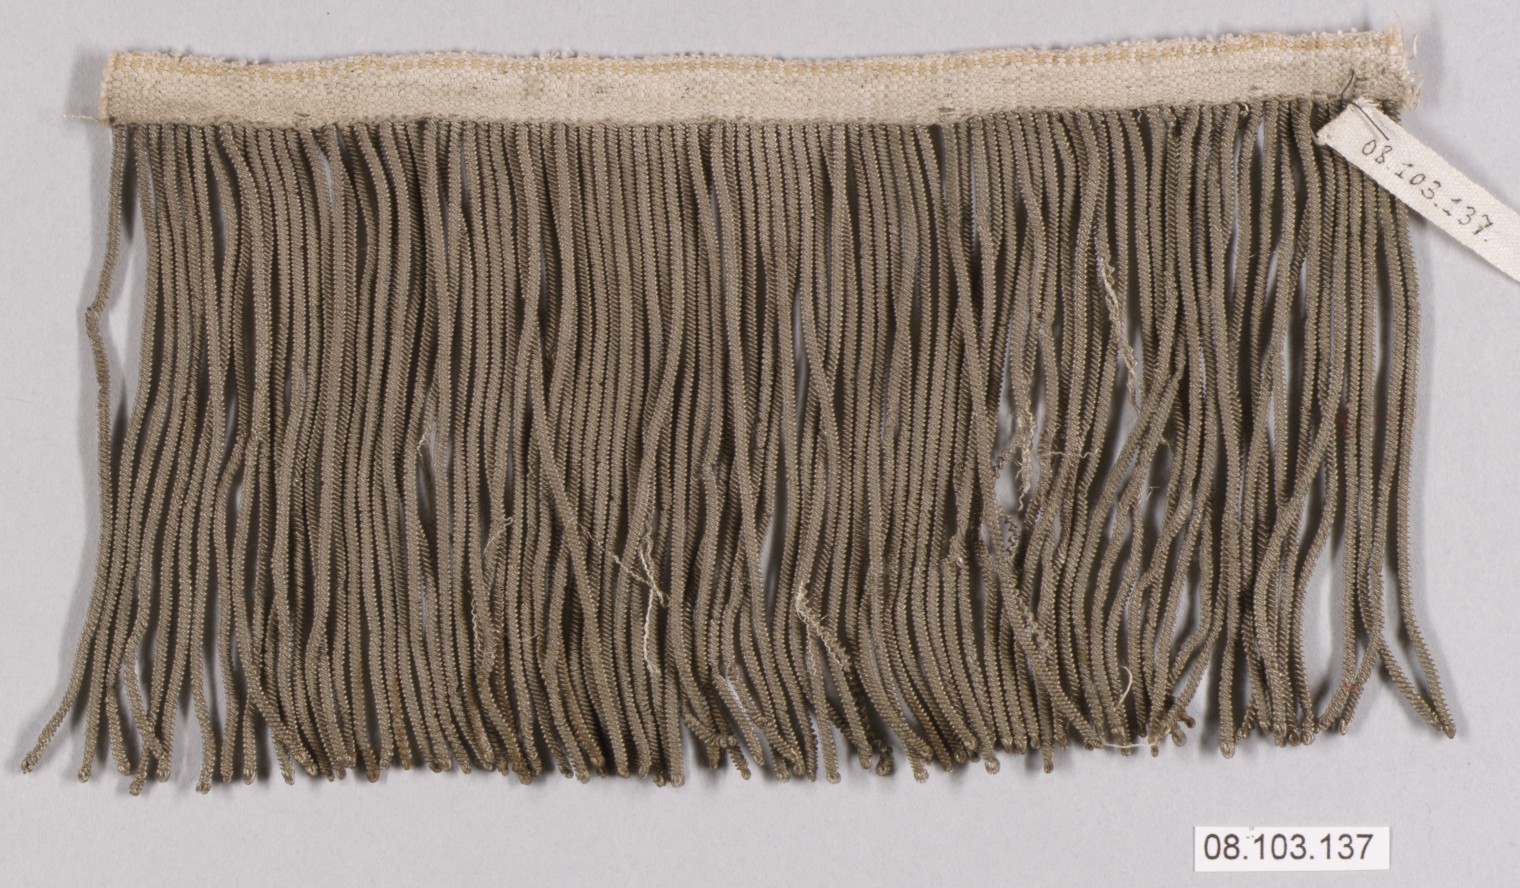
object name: fringe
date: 1801-1900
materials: cotton, metal thread